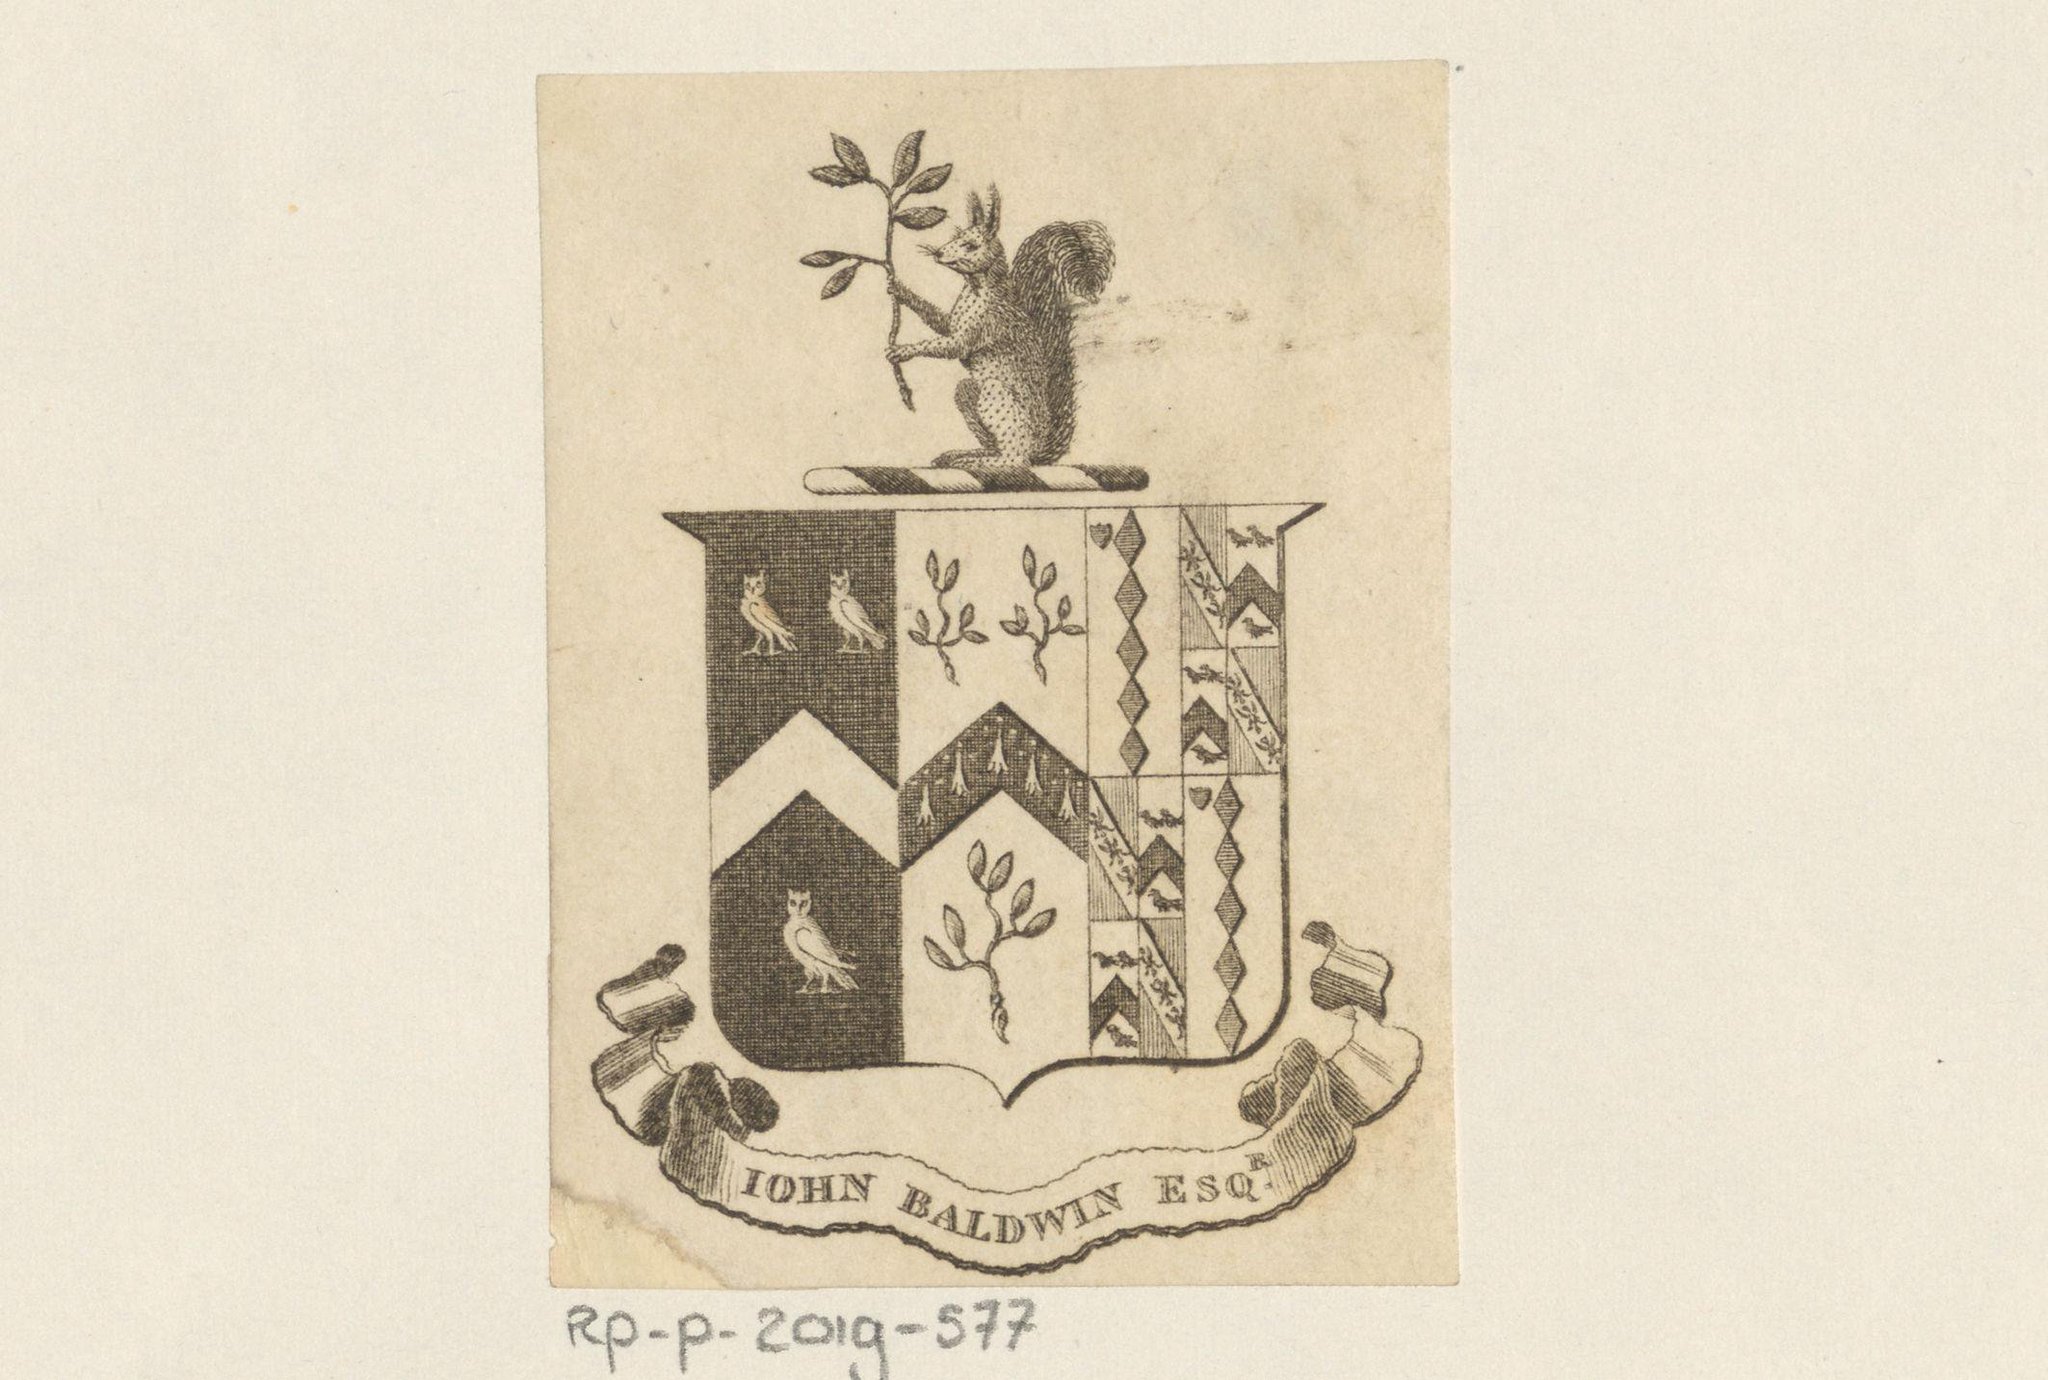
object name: bookplate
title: Ex libris van John Baldwin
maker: Anonymous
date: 1700-1799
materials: paper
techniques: etching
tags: armorial bearing, heraldry